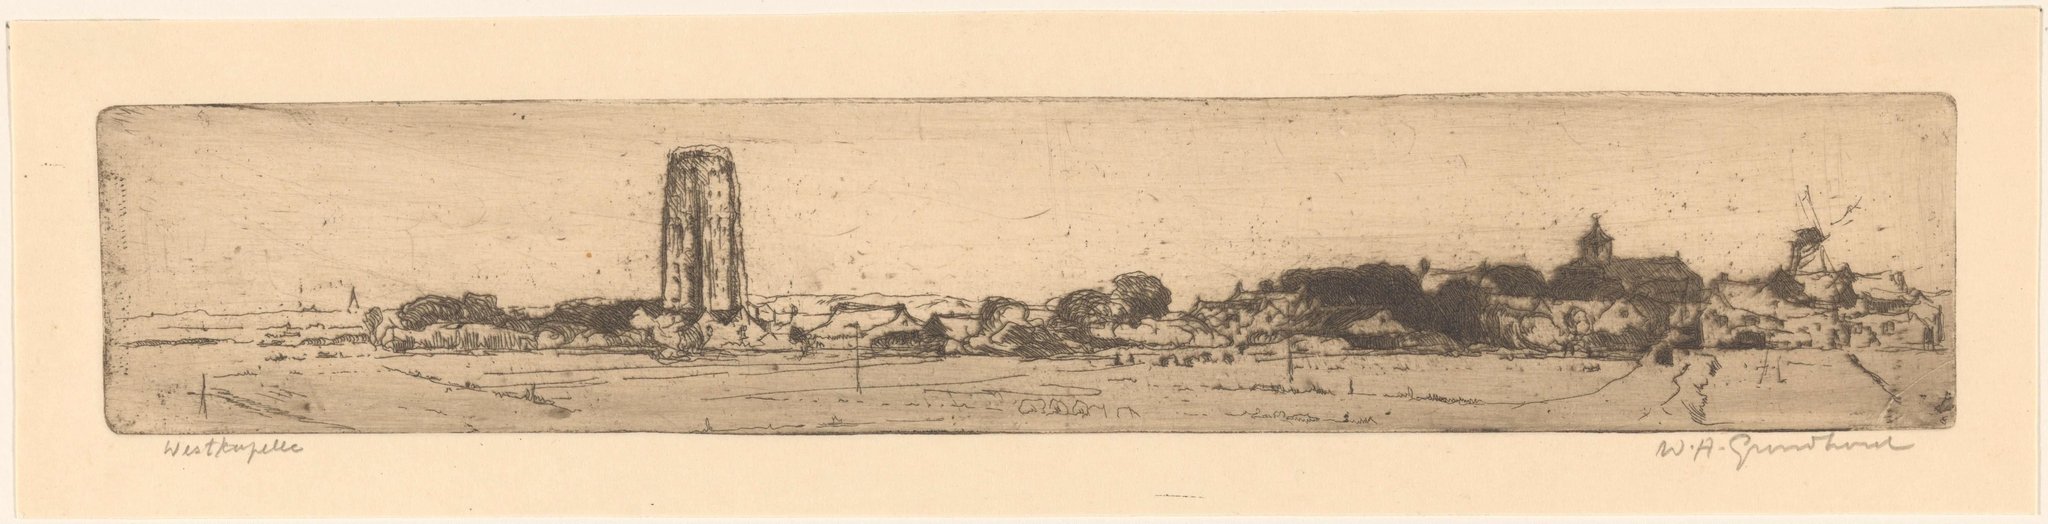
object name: print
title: Westkapelle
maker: willem adrianus grondhout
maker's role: draughtsman, painter, print maker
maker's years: 1878-1934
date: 1888-1931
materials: paper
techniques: etching, intaglio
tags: lighthouse, lightship, city-view, and landscape with man-made constructions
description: Het Zeeuwse Westkapelle, met links van het midden de vuurtoren en geheel rechts een molen.